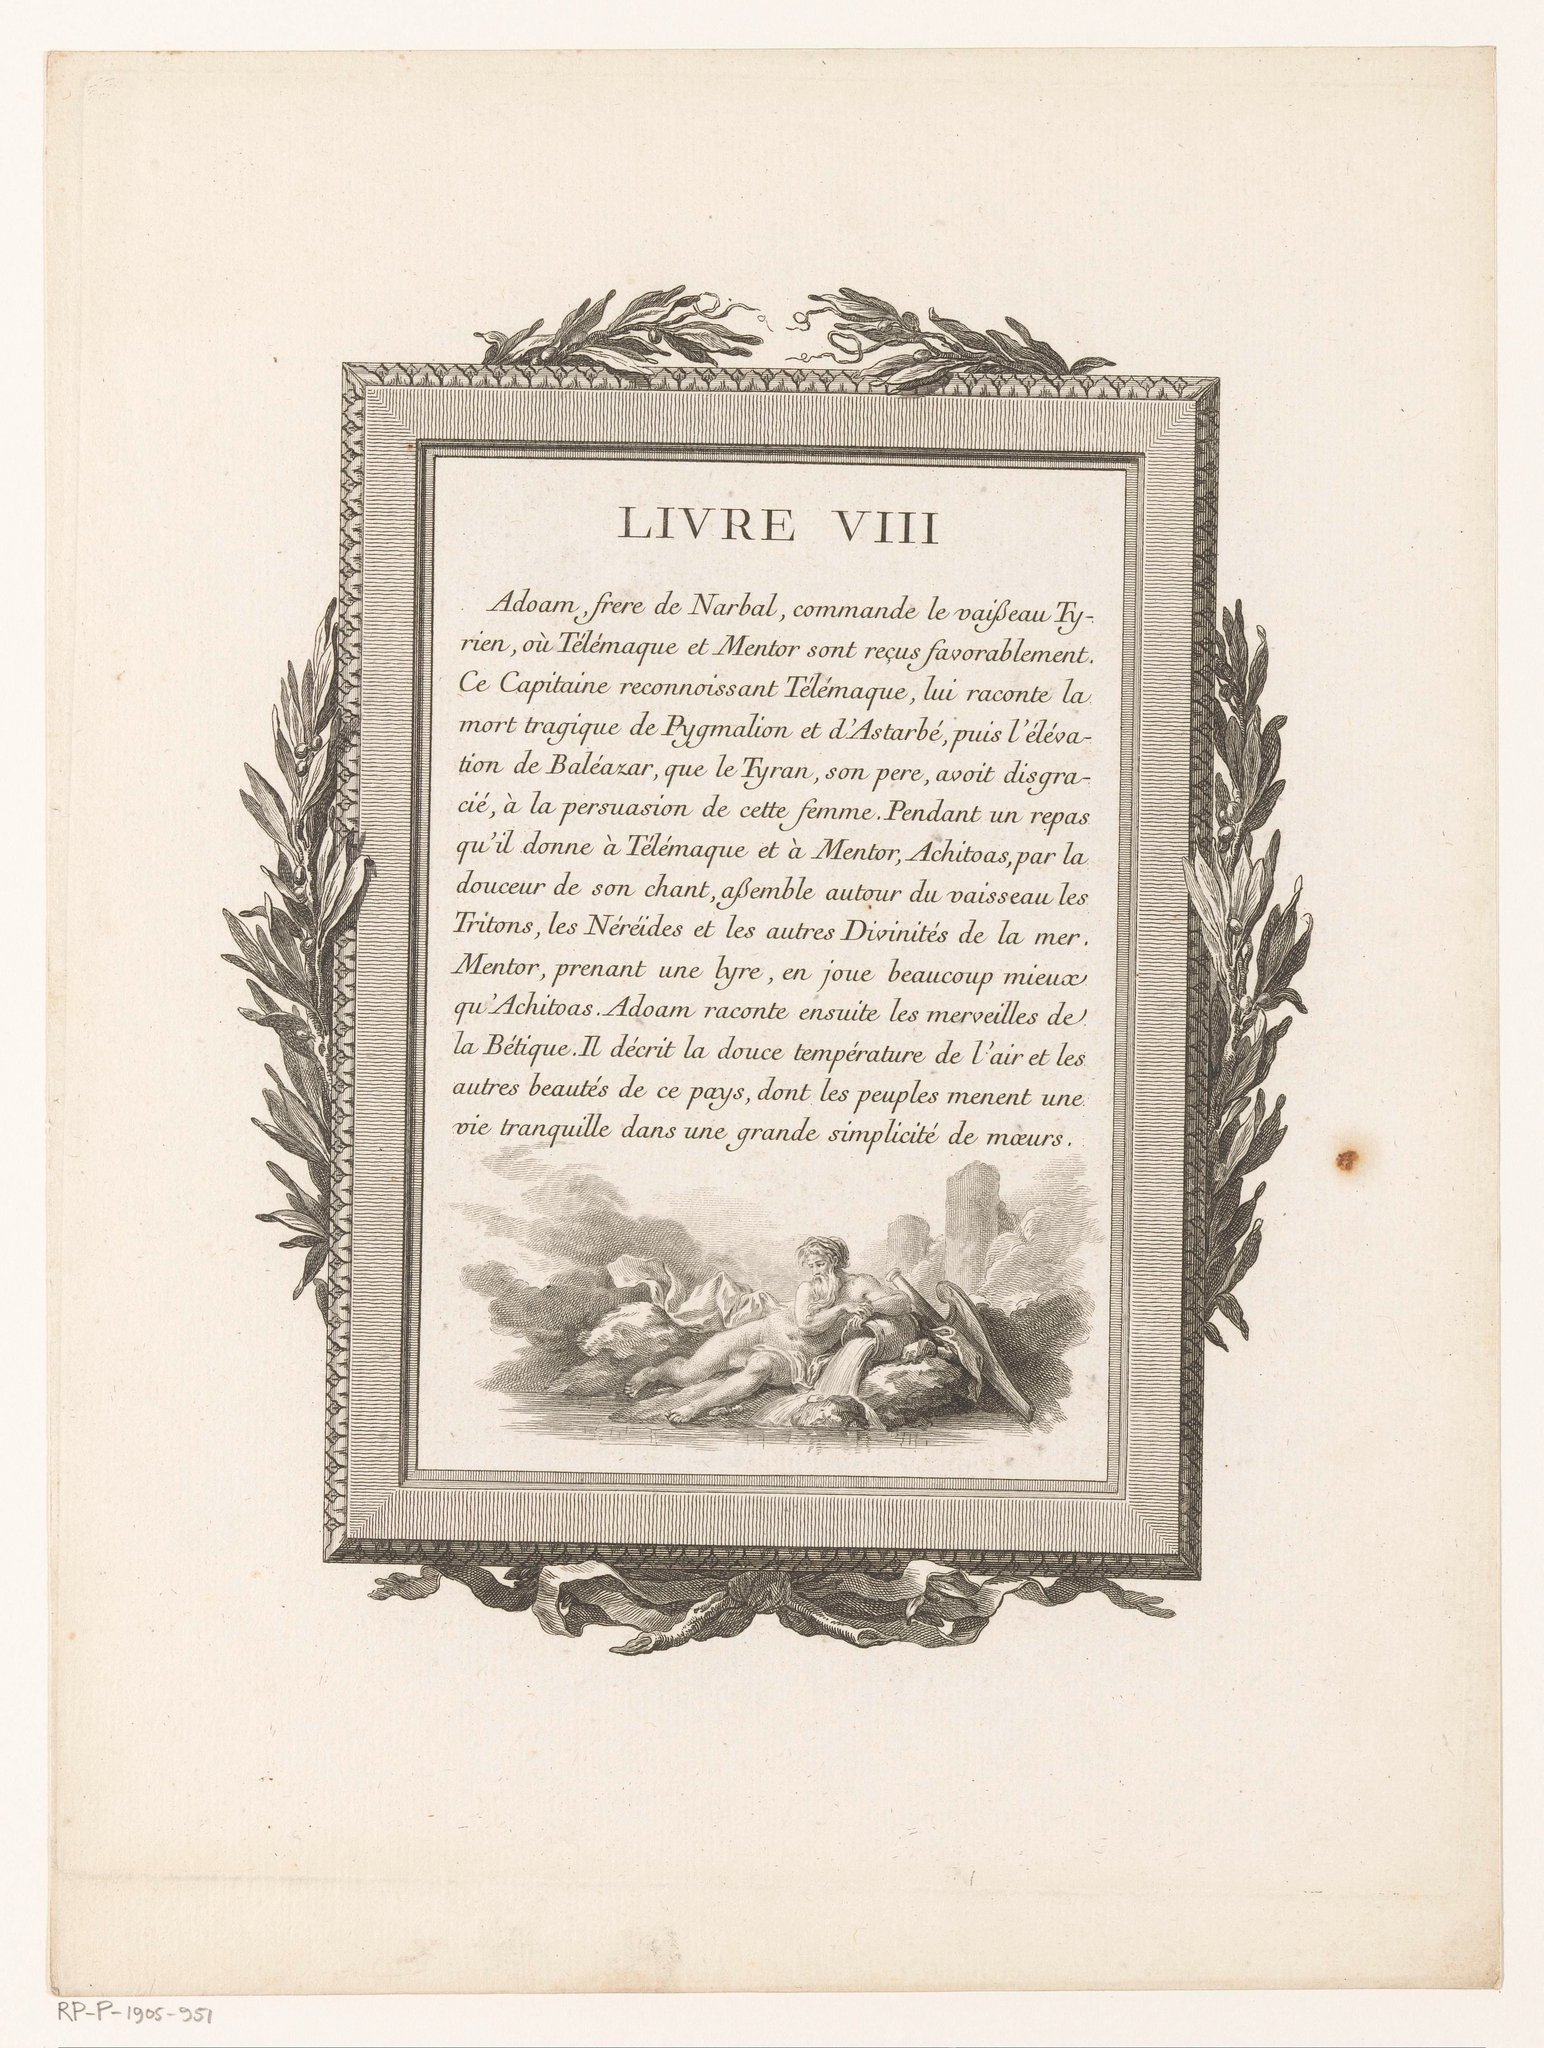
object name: print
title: Omkaderde Franse tekst met een riviergod en olijftakken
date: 1785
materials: paper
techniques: engraving, etching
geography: france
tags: (fenelon, telemachus) specific works of literature (with author, title), river-gods, ornament ~ festoon, garland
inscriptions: collector's mark: Lugt 2228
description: Veertienregelige Franse tekst, getiteld 'Livre VIII' met daaronder een afbeelding van een riviergod. Het geheel wordt gekaderd door een sierlijst met olijftakken en onderaan een strik.